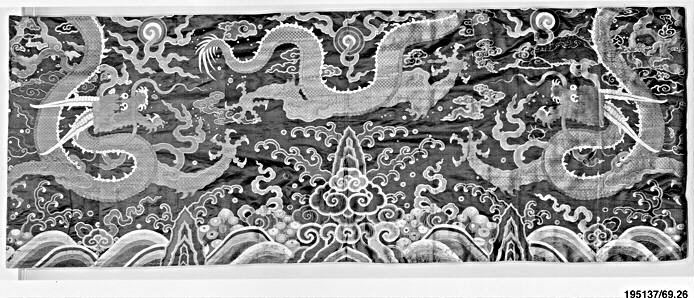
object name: imperial curtain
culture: chinese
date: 1667-1733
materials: cotton, metal thread, silk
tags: dragons